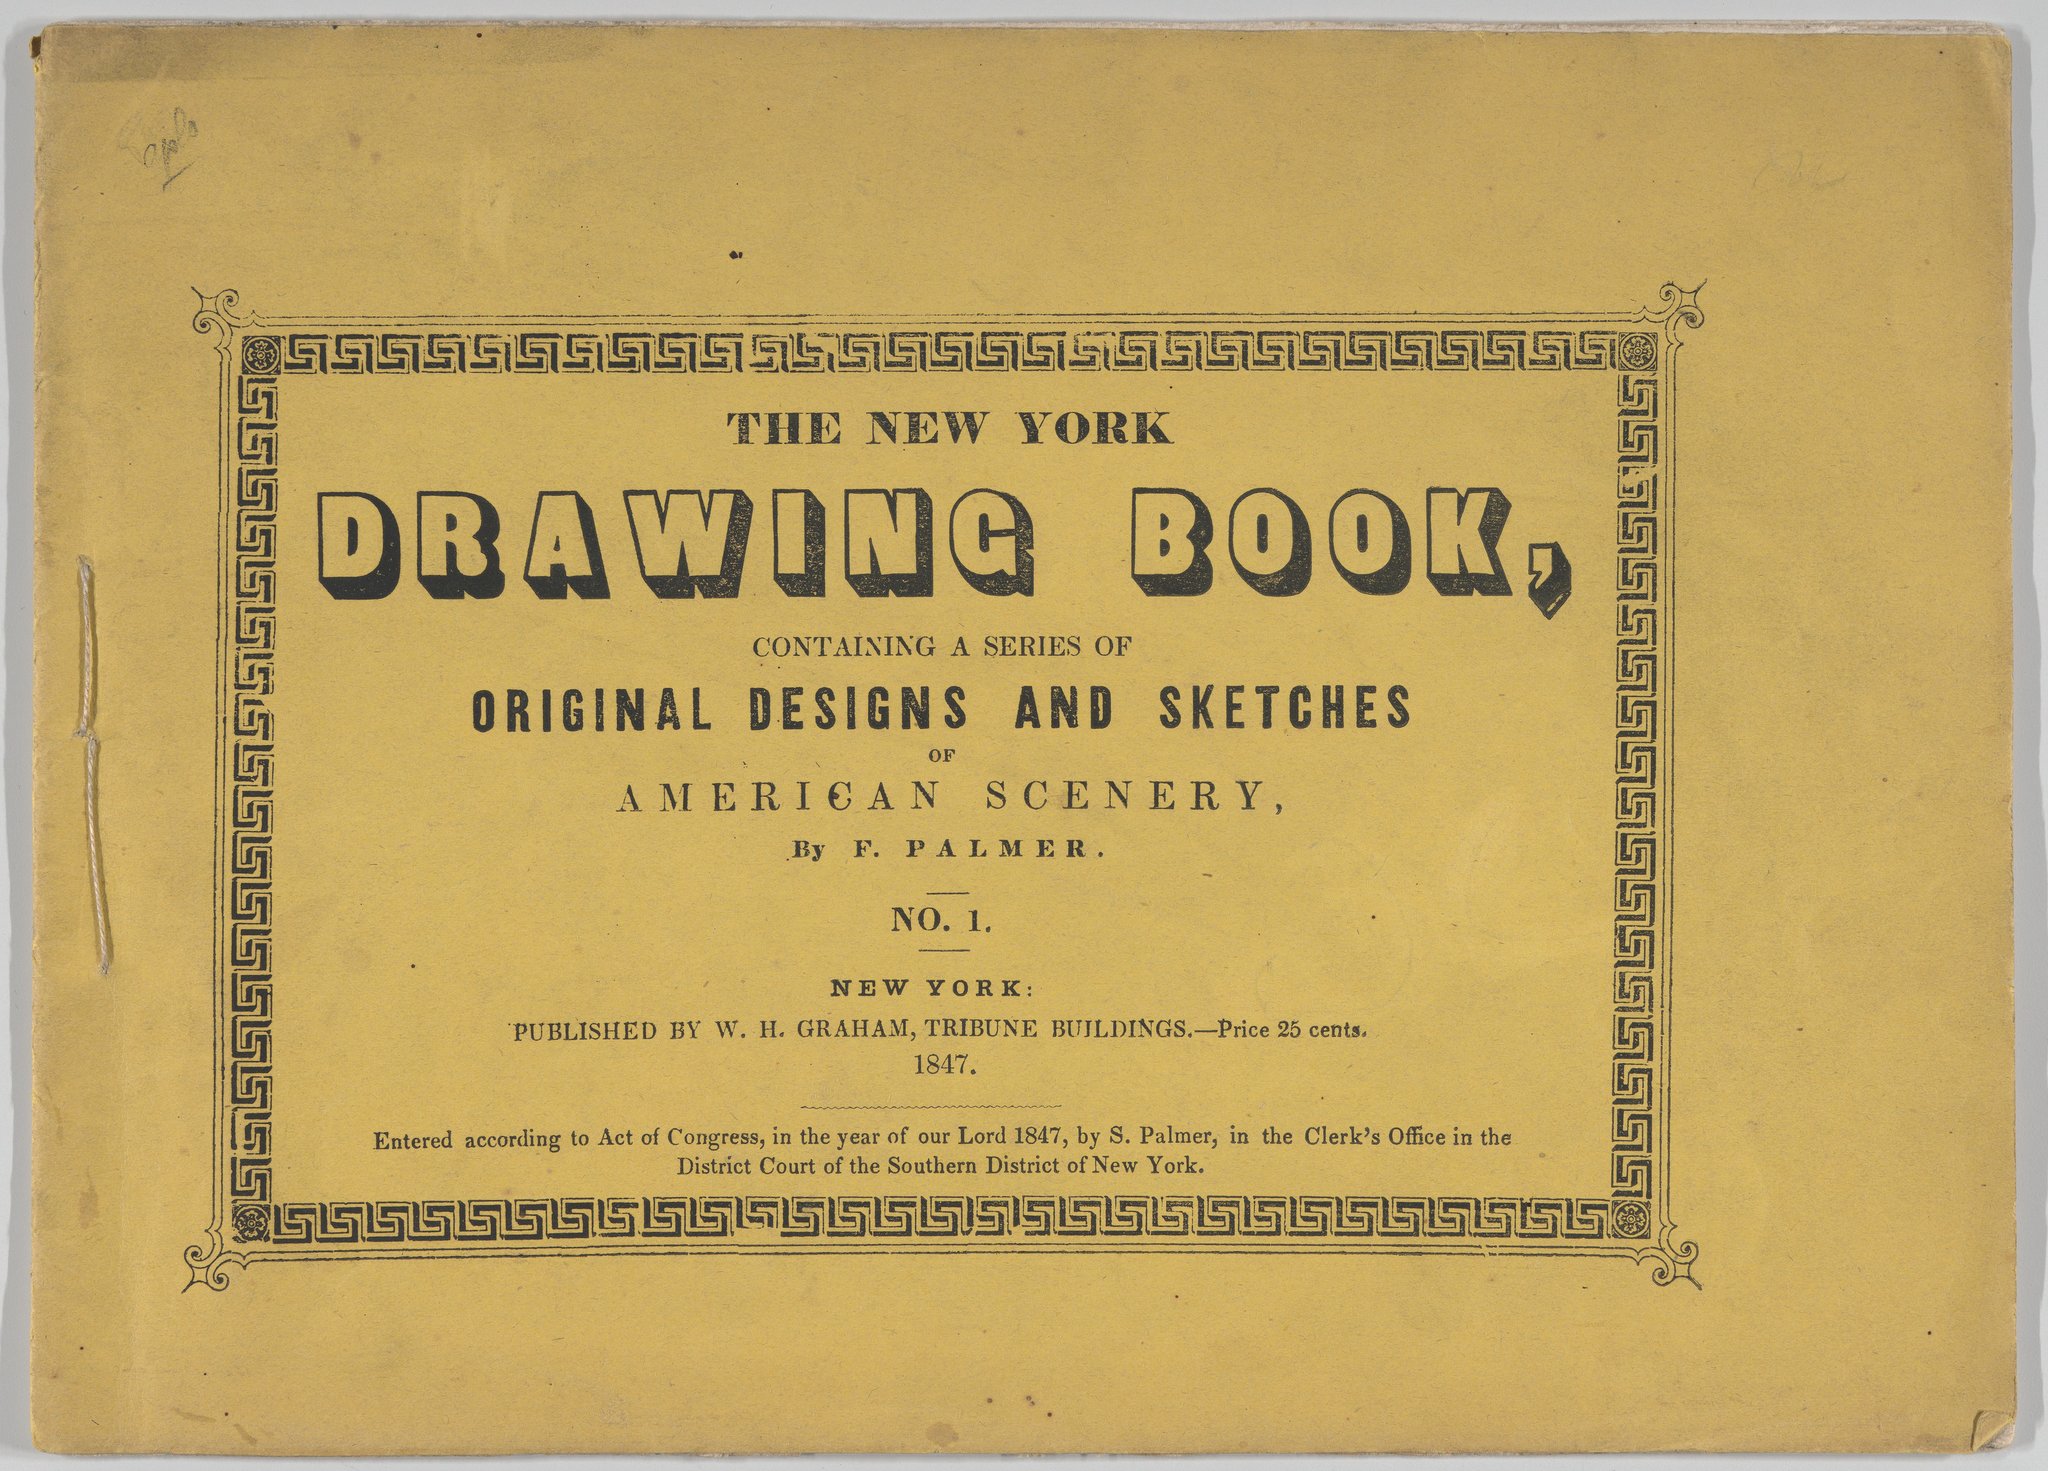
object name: book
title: The New York Drawing Book, Containing a Series of Original Designs and Sketches of American Scenery, by F. Palmer, No. 1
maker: frances flora bond palmer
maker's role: artist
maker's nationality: american, born england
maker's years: 1812-1876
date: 1847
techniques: lithograph